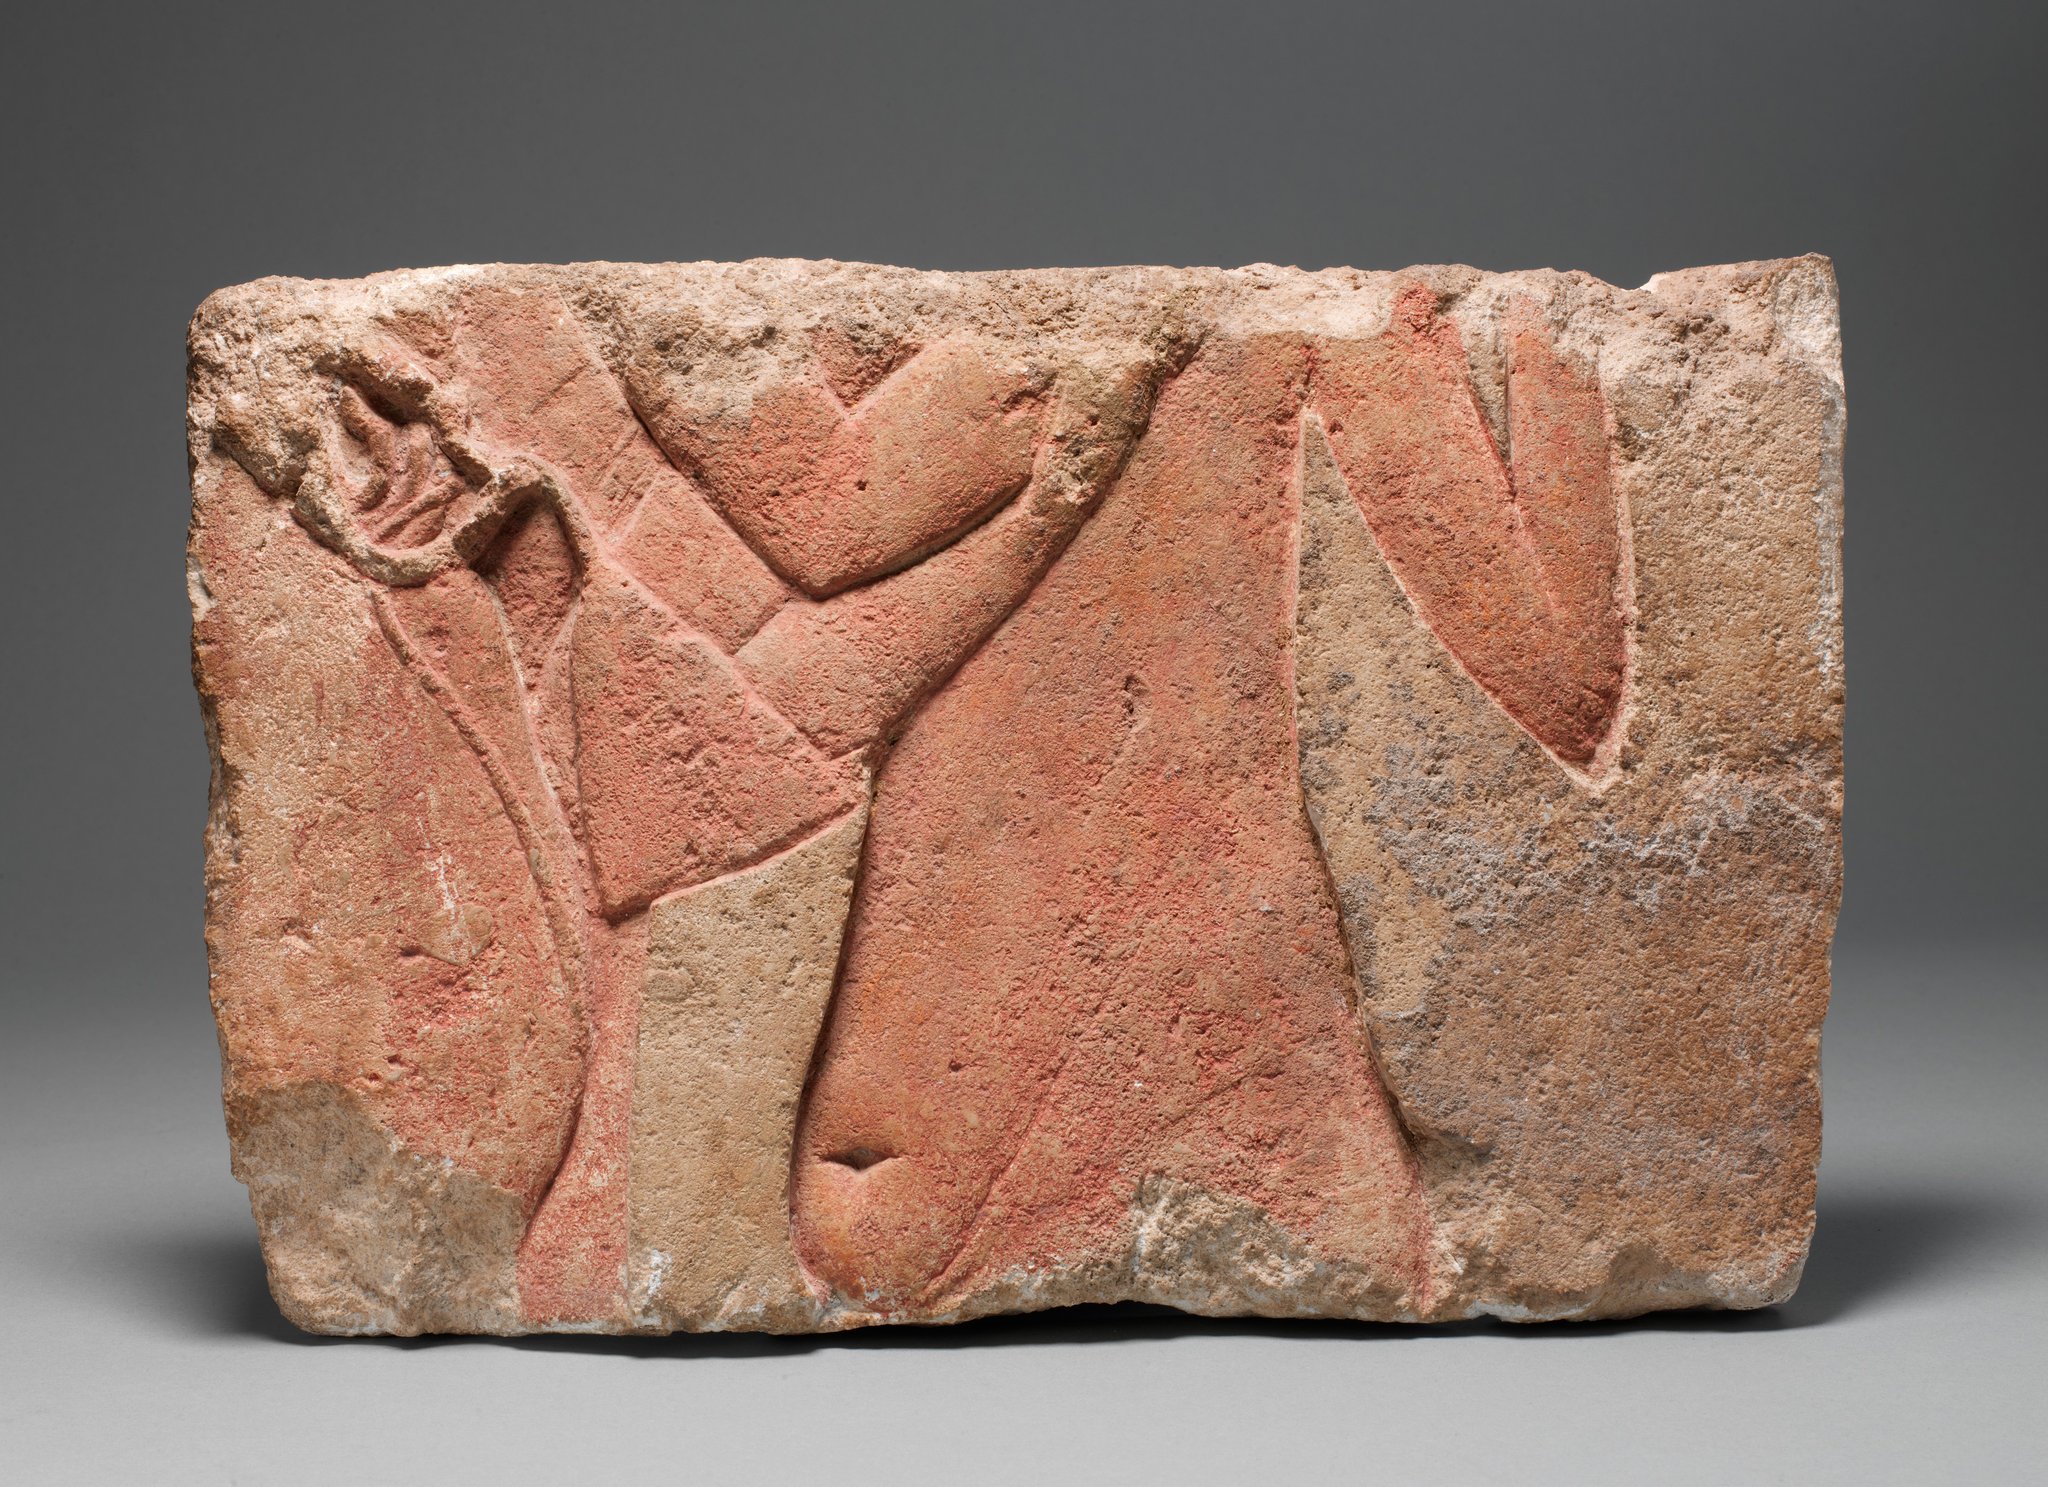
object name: talatat, two royal male figure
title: Relief with two royal male figures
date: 1353-1336 BCE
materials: limestone, paint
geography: egypt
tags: men